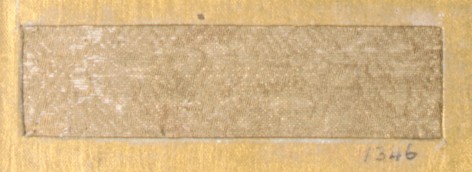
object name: piece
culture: japanese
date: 1701-1900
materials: silk